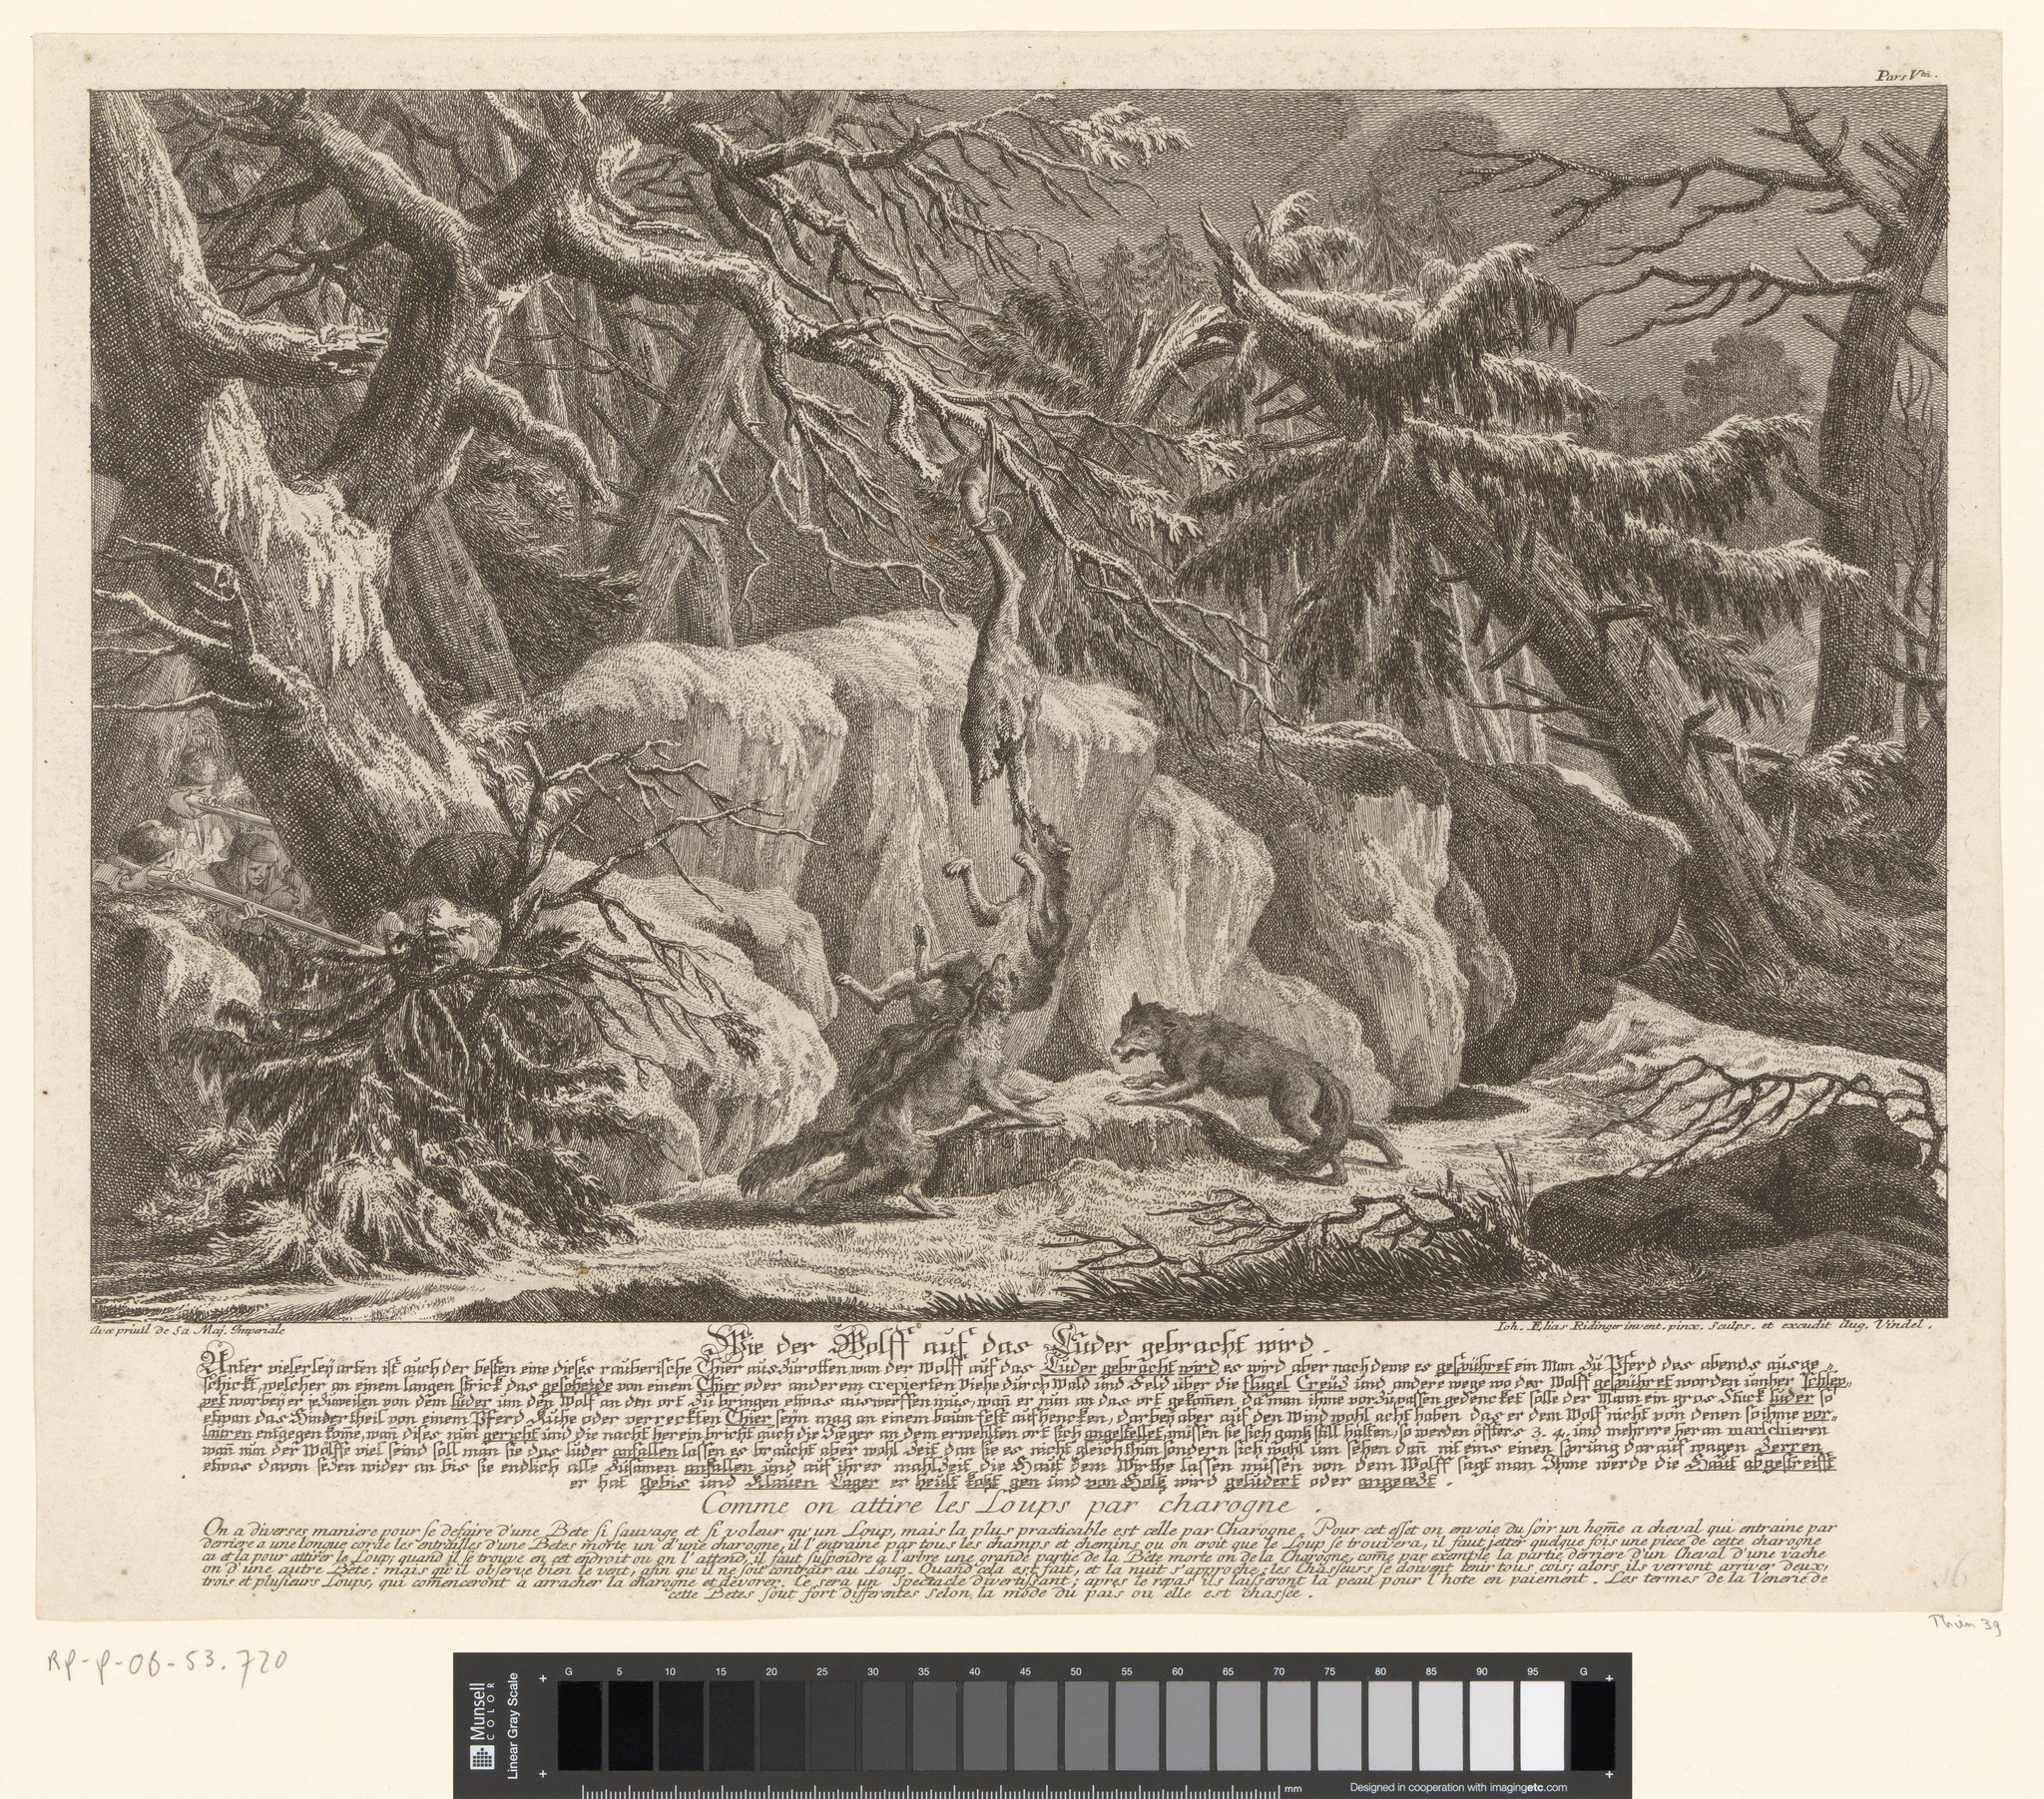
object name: print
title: Jagers schieten op wolven die worden gelokt door een dood beest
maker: johann elias ridinger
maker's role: draughtsman, painter, print maker, publisher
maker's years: 1698-1767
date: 1729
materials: paper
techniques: etching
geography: augsburg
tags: hunt ~animals (lures ~hunting), forest, wood, hunt ~ mammals, beasts of prey, predatory animals: wolf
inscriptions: collector's mark: Lugt 240